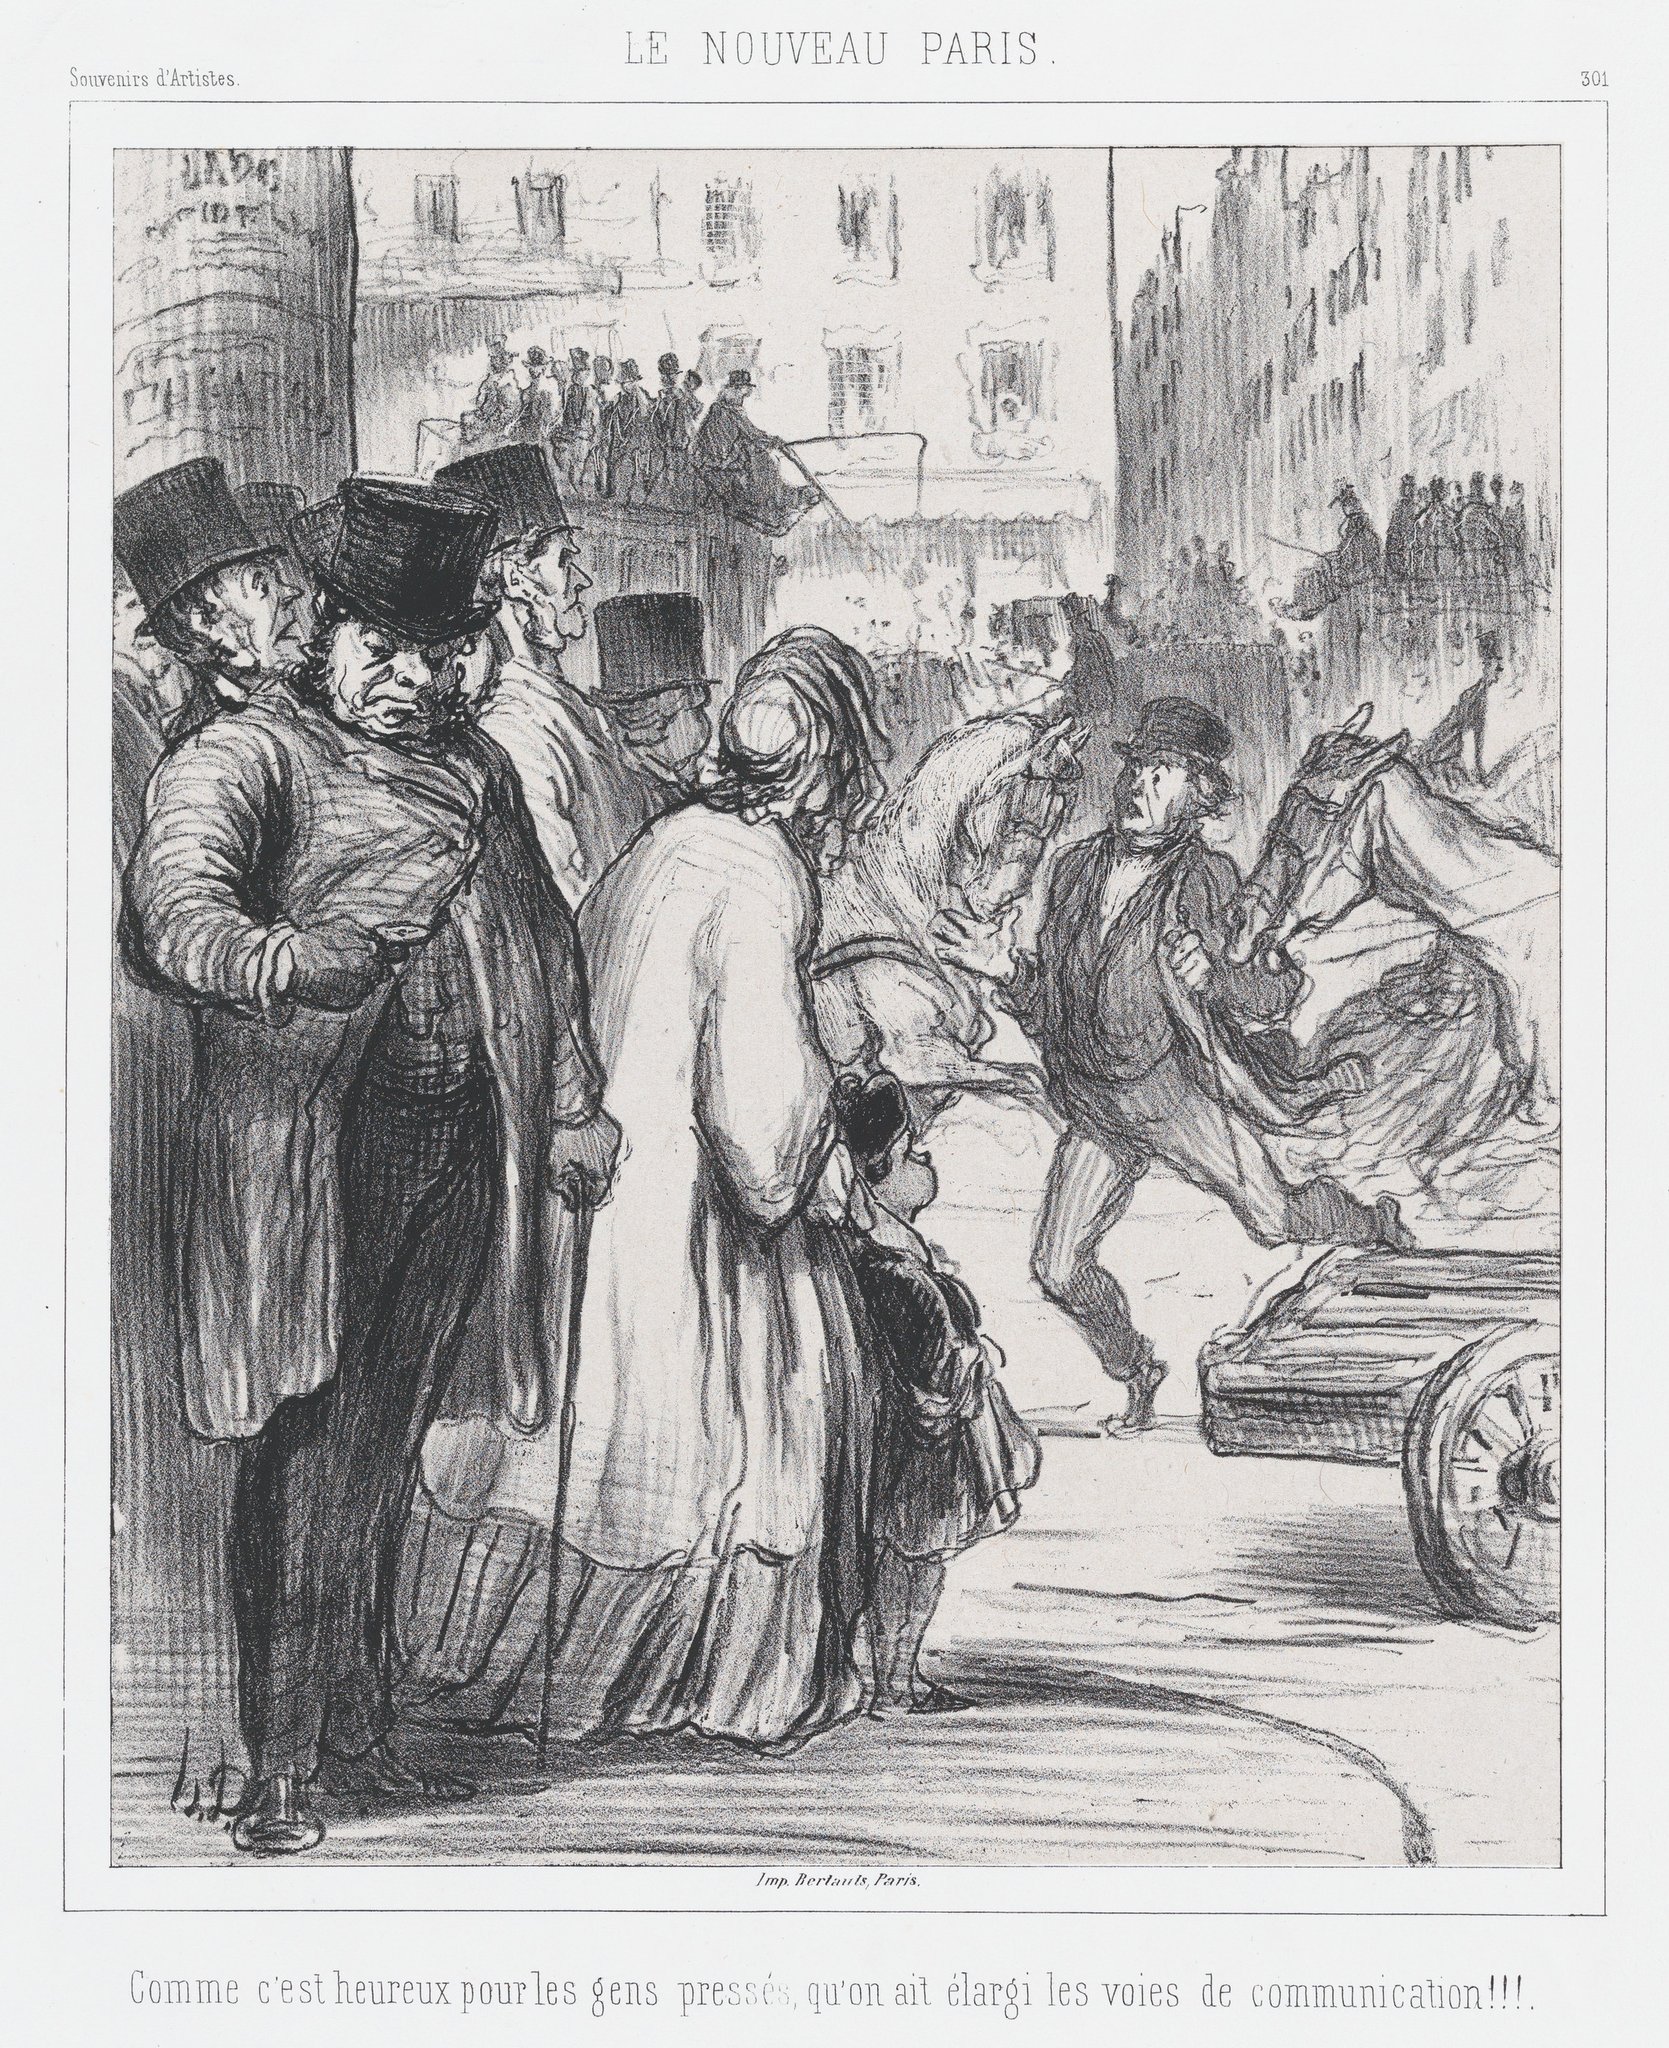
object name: print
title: The New Paris, How fortunate for those in a hurry that the avenues have been widened!!!, published in Souvenirs d'Artistes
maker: honoré daumier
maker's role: artist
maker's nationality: french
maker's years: 1808-1879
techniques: lithograph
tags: buildings,streets,men,horses